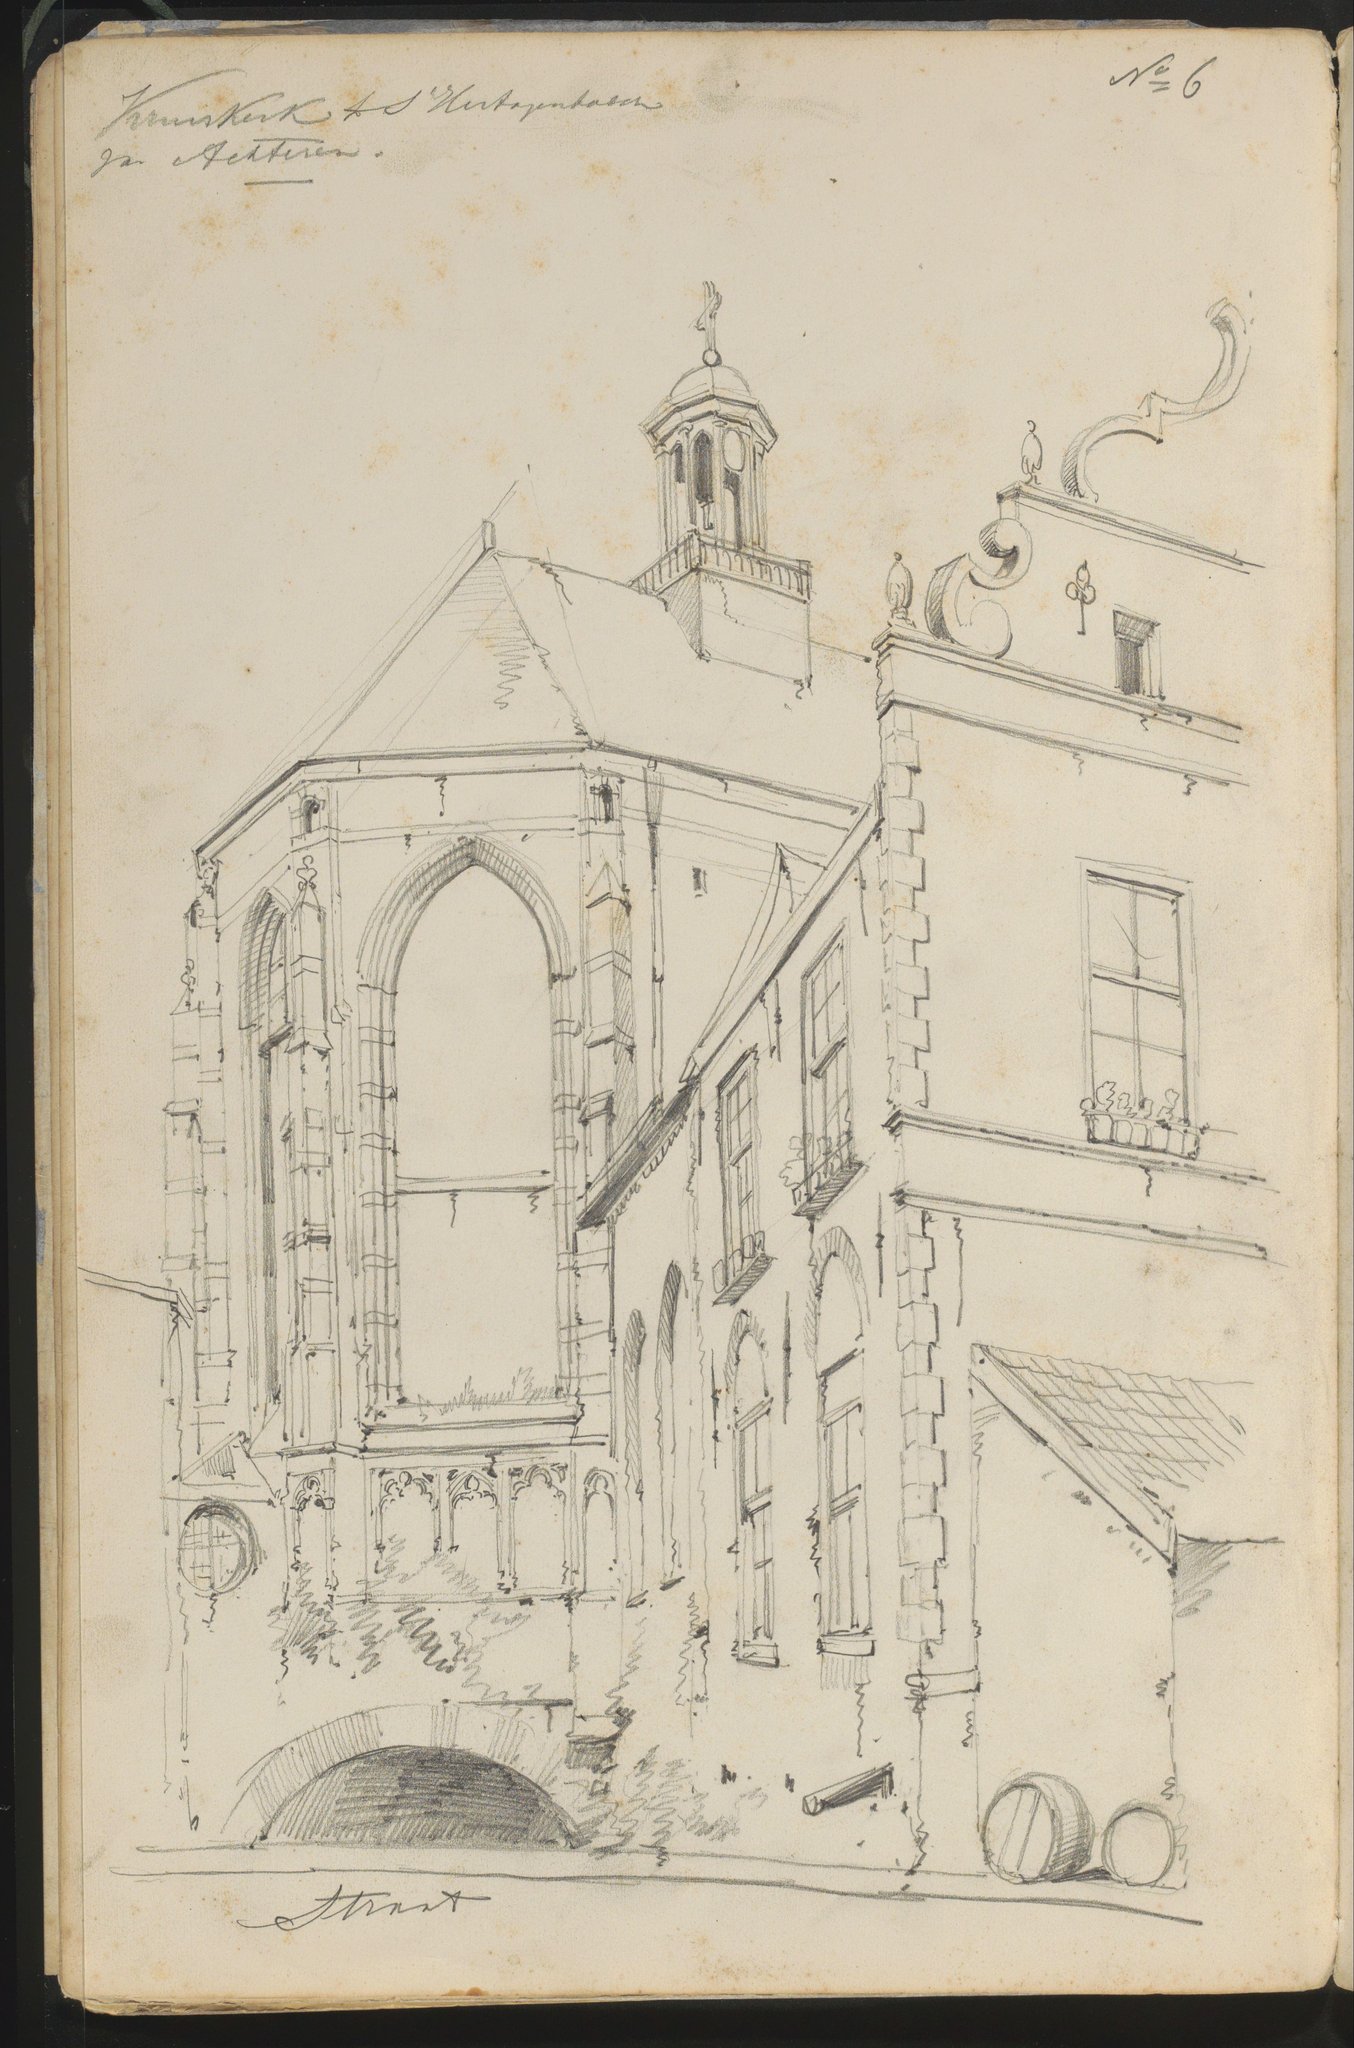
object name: sketchbook leaf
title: Gezicht op het koor van de Sint-Catharinakerk te Den Bosch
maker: willem koekkoek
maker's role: draughtsman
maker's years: 1839-1895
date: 1849-1895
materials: paper, pencil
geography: den bosch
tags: church (exterior)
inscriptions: annotation: ‘Kruiskerk te s Hertogenbosch No 6/ van Achteren./ straat’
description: Blad 6 verso uit een schetsboek met 35 bladen.